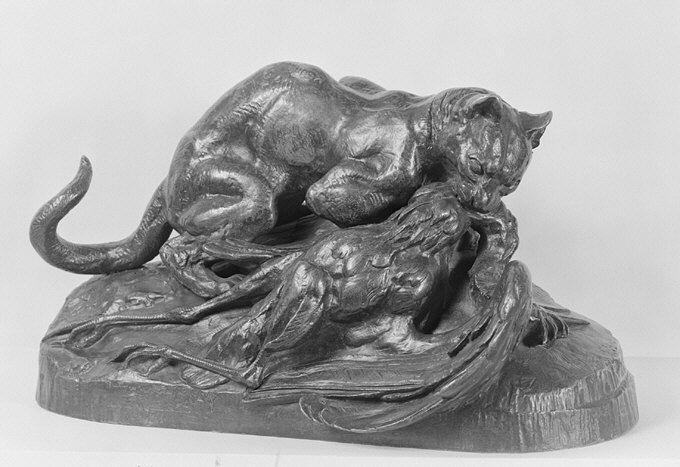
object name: statuette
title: Ocelot Devouring a Heron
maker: antoine-louis barye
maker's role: artist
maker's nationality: french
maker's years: 1795-1875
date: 1801-1900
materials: bronze, patina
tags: birds,cats